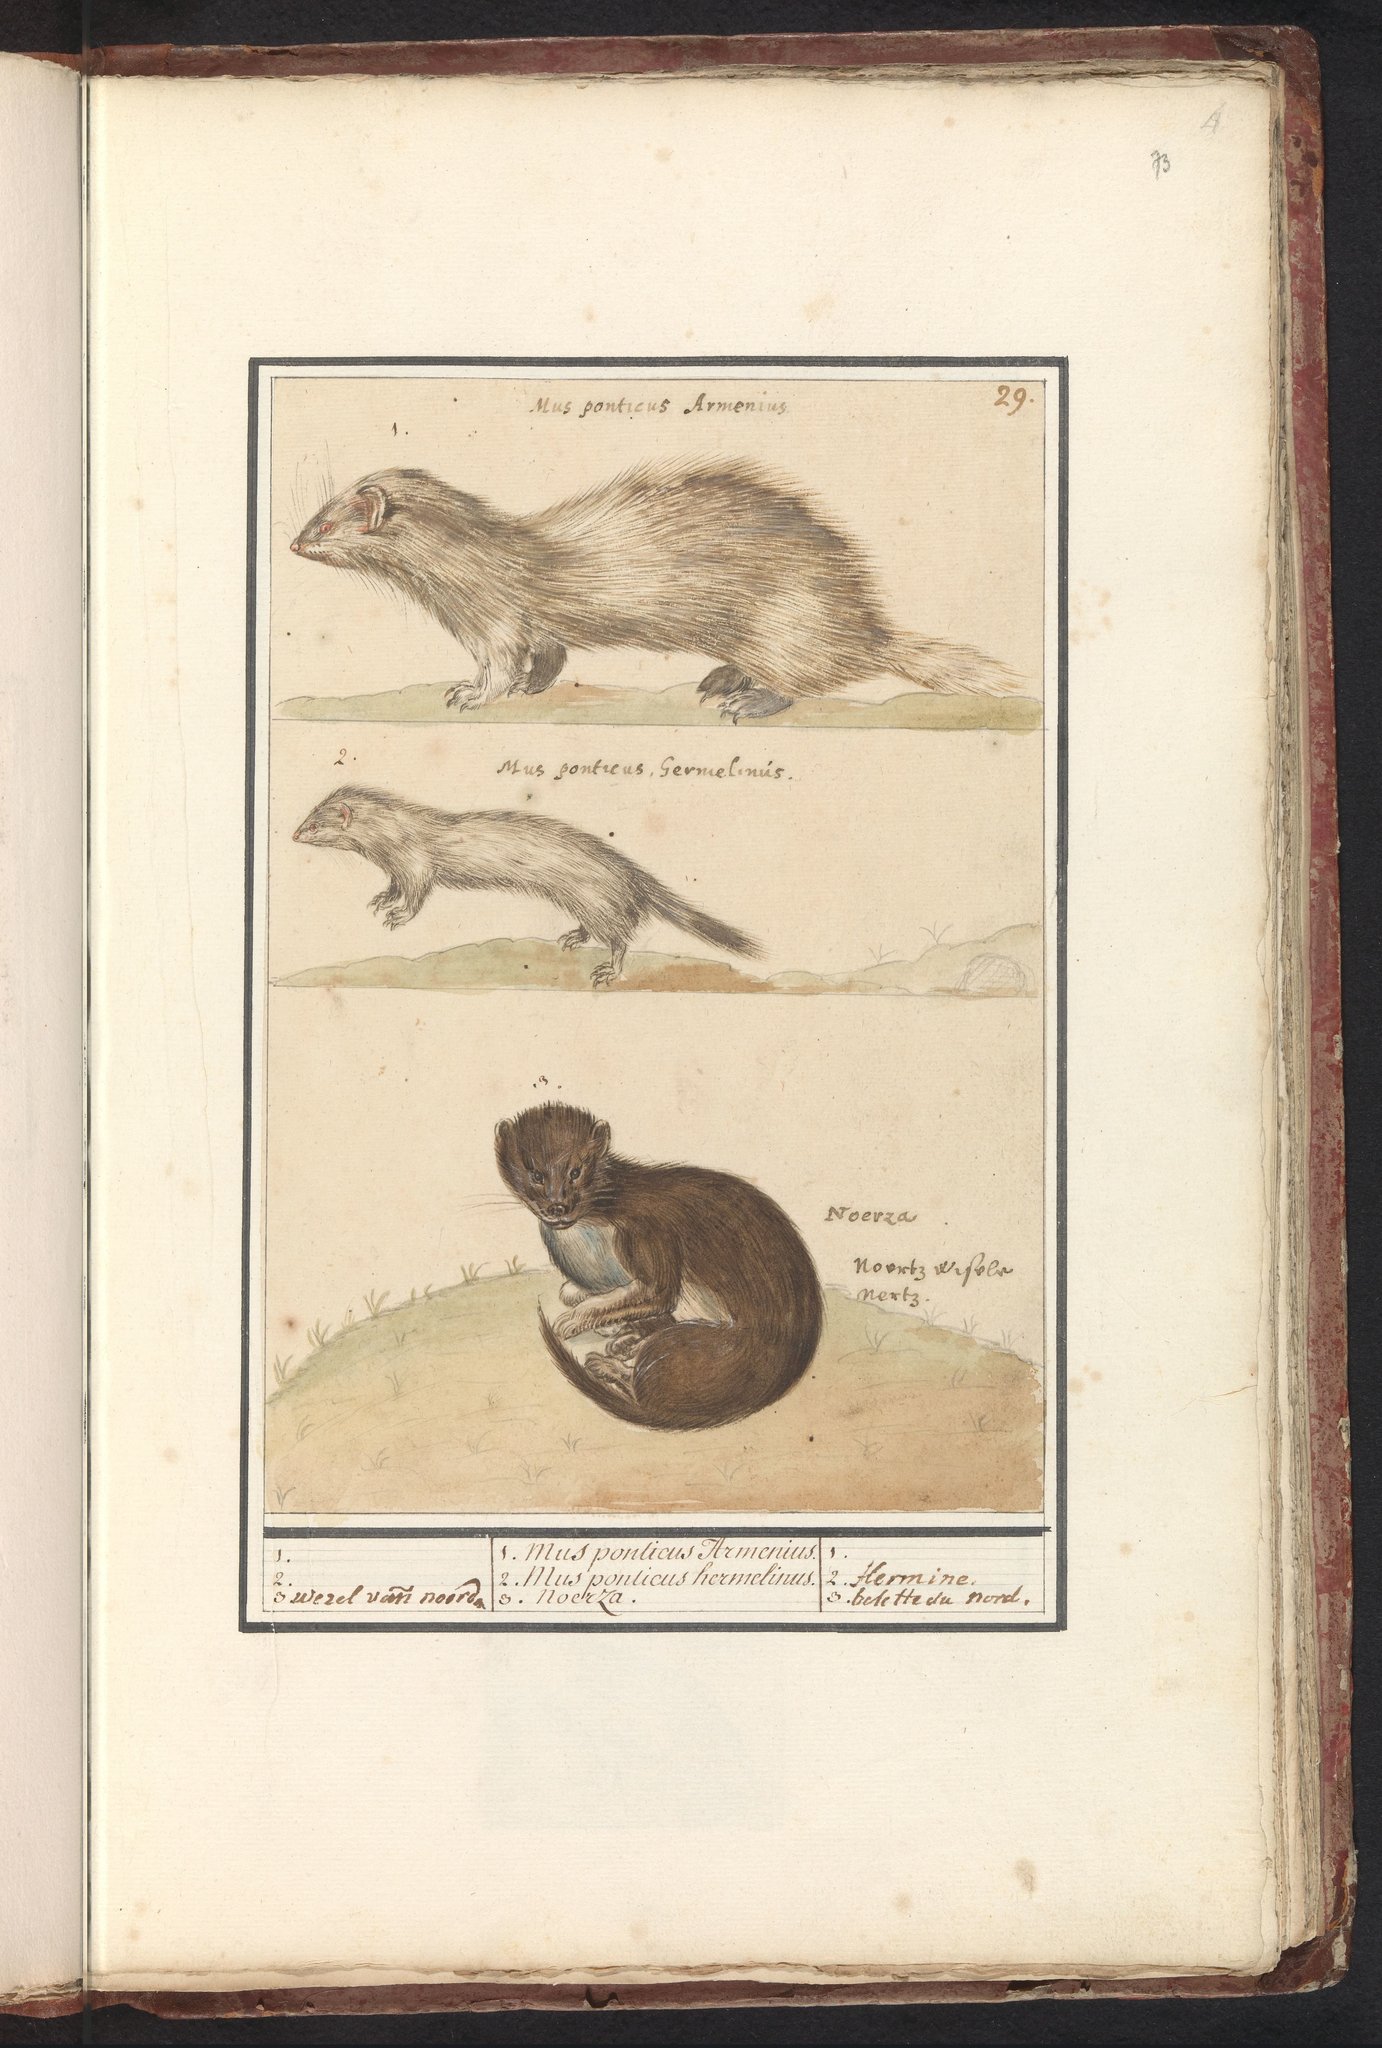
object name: drawing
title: 1. 2. 3 Wezel van noorden / 1. Mus ponticus Armenius. 2. Mus ponticus hermelinus. 3. Noerza. / 1. 2. Hermine 3. belette du nord.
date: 1596-1610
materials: paint, ink, paper, watercolor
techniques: brush, pen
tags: beasts of prey, predatory animals: stoat, beasts of prey, predatory animals: mink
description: Twee hermelijnen en een nerts genummerd 1-3 met bijbehorende Latijnse namen. Rechtsboven genummerd: 29. Onderdeel van het eerste album met tekeningen van viervoeters. Eerste van twaalf albums met tekeningen van dieren, vogels en planten bekend rond 1600, gemaakt in opdracht van keizer Rudolf II. Met toelichting in Nederlands, Latijn en Frans.